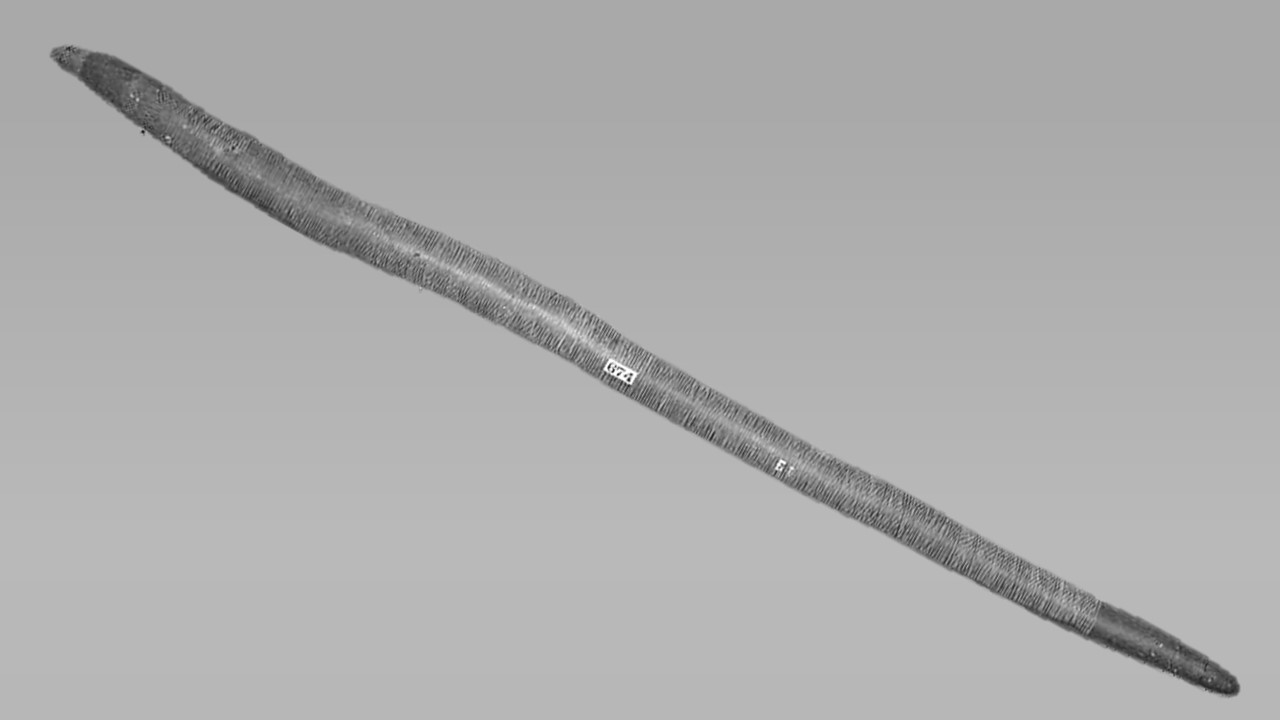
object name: güiro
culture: native american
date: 1867-1900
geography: united states